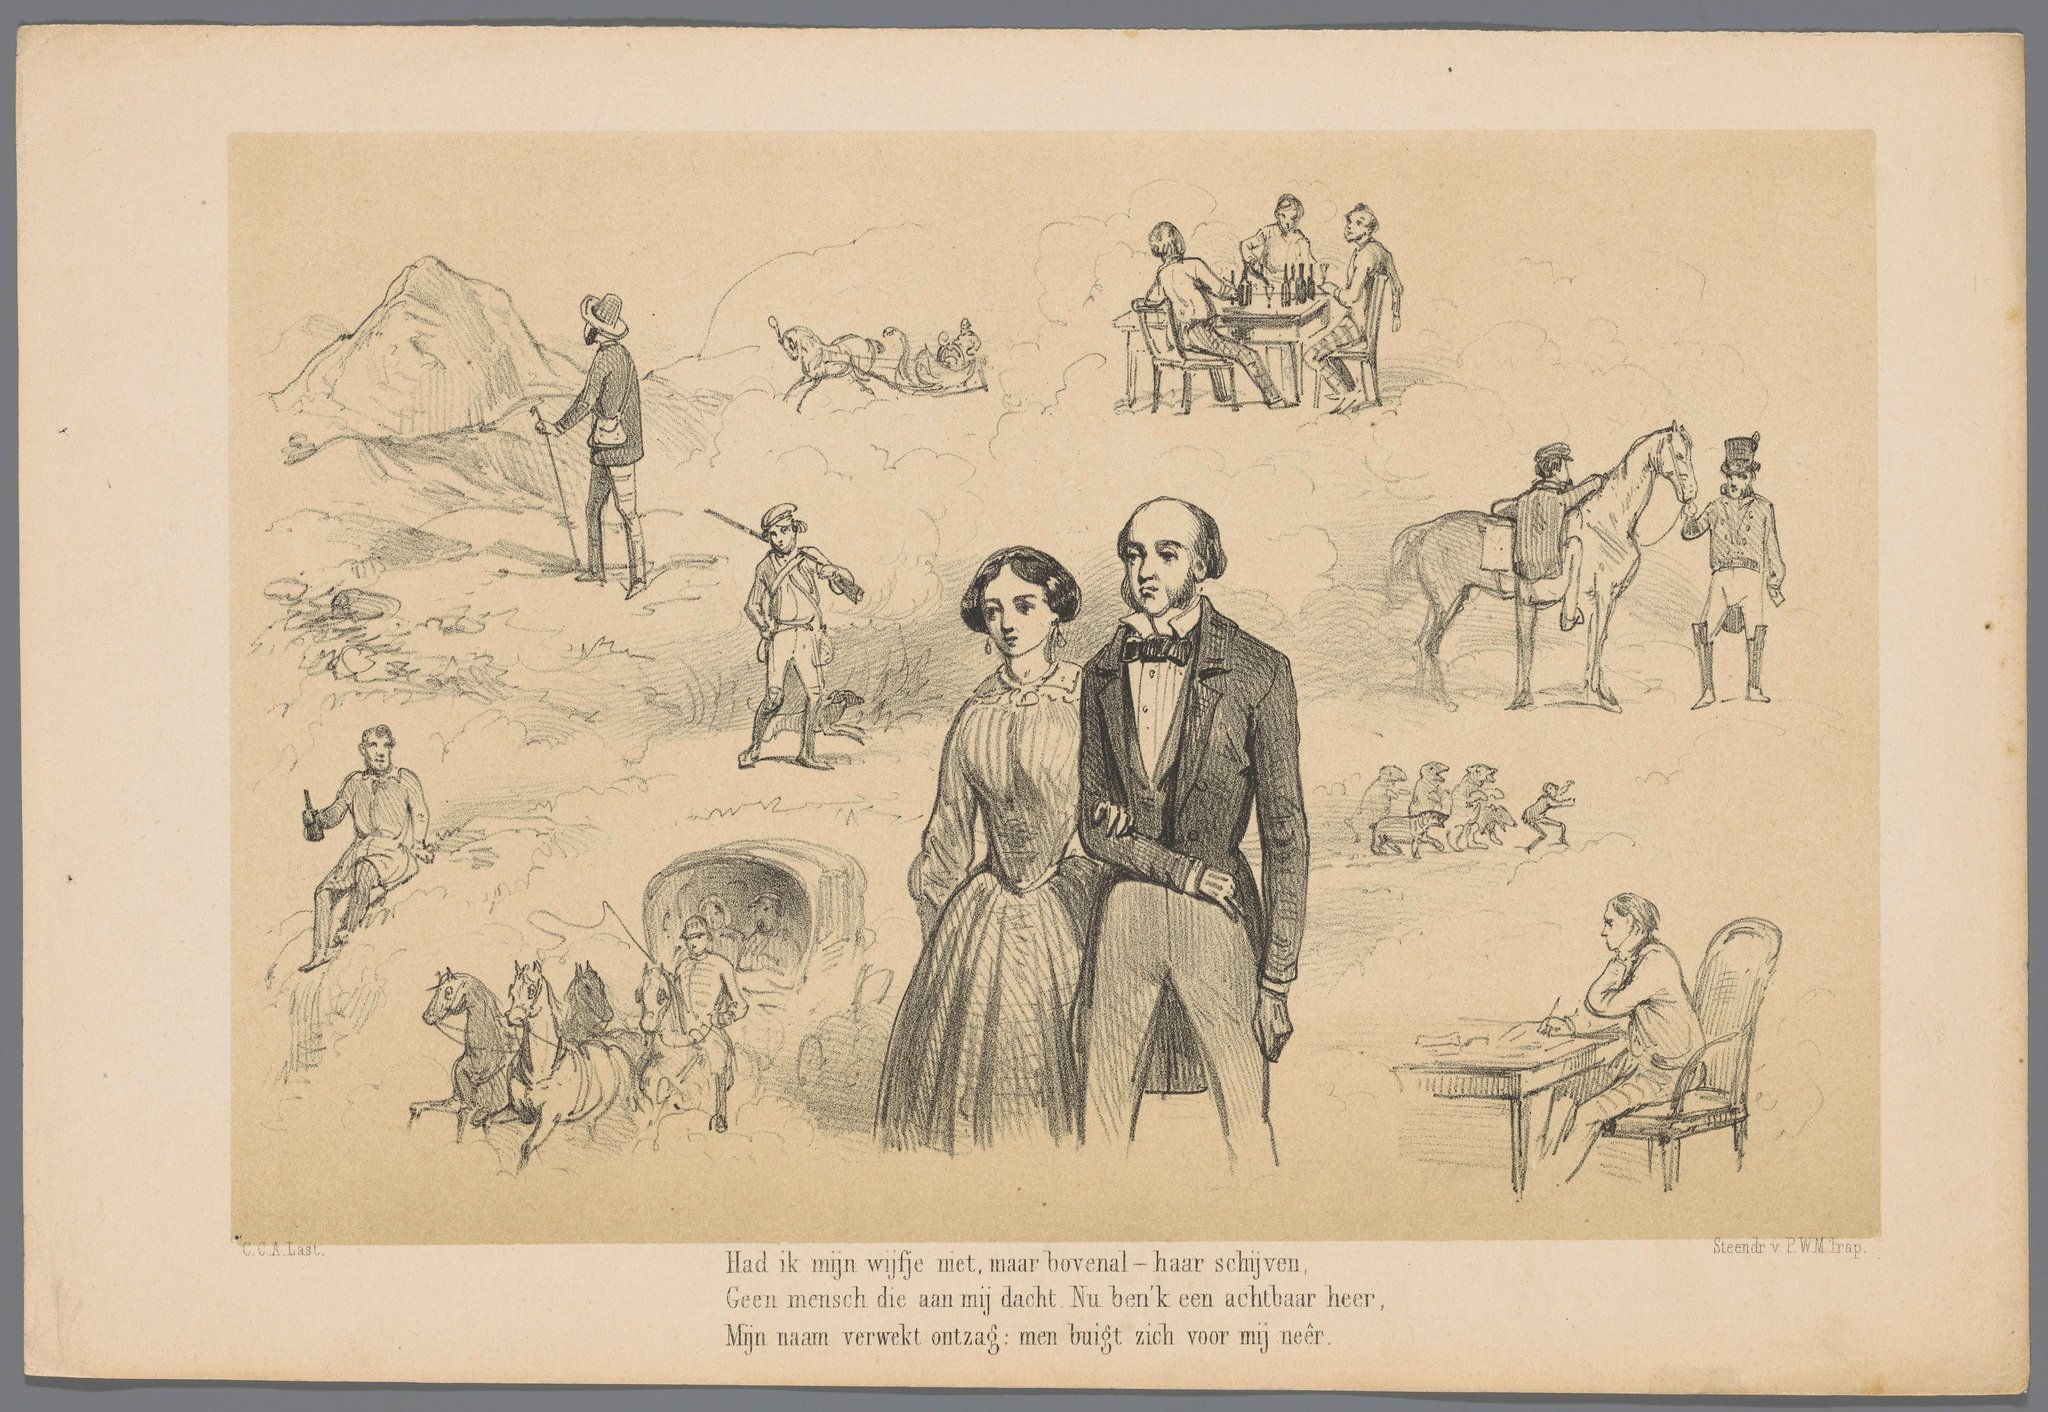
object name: print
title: Echtpaar omringd door gebeurtenissen uit het verleden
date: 1836-1867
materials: paper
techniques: tone lithography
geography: leiden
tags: student life, arm in arm (lovers)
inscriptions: collector's mark: Lugt 2228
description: De serie met omslag werd samengesteld door Jan van der Hoeven (Leiden 1834 - Rotterdam 1900). Van der Hoeven was mede oprichter van het Sophia-Kinderziekenhuis in Rotterdam en was als heelmeester verbonden aan het stedelijk ziekenhuis aldaar.